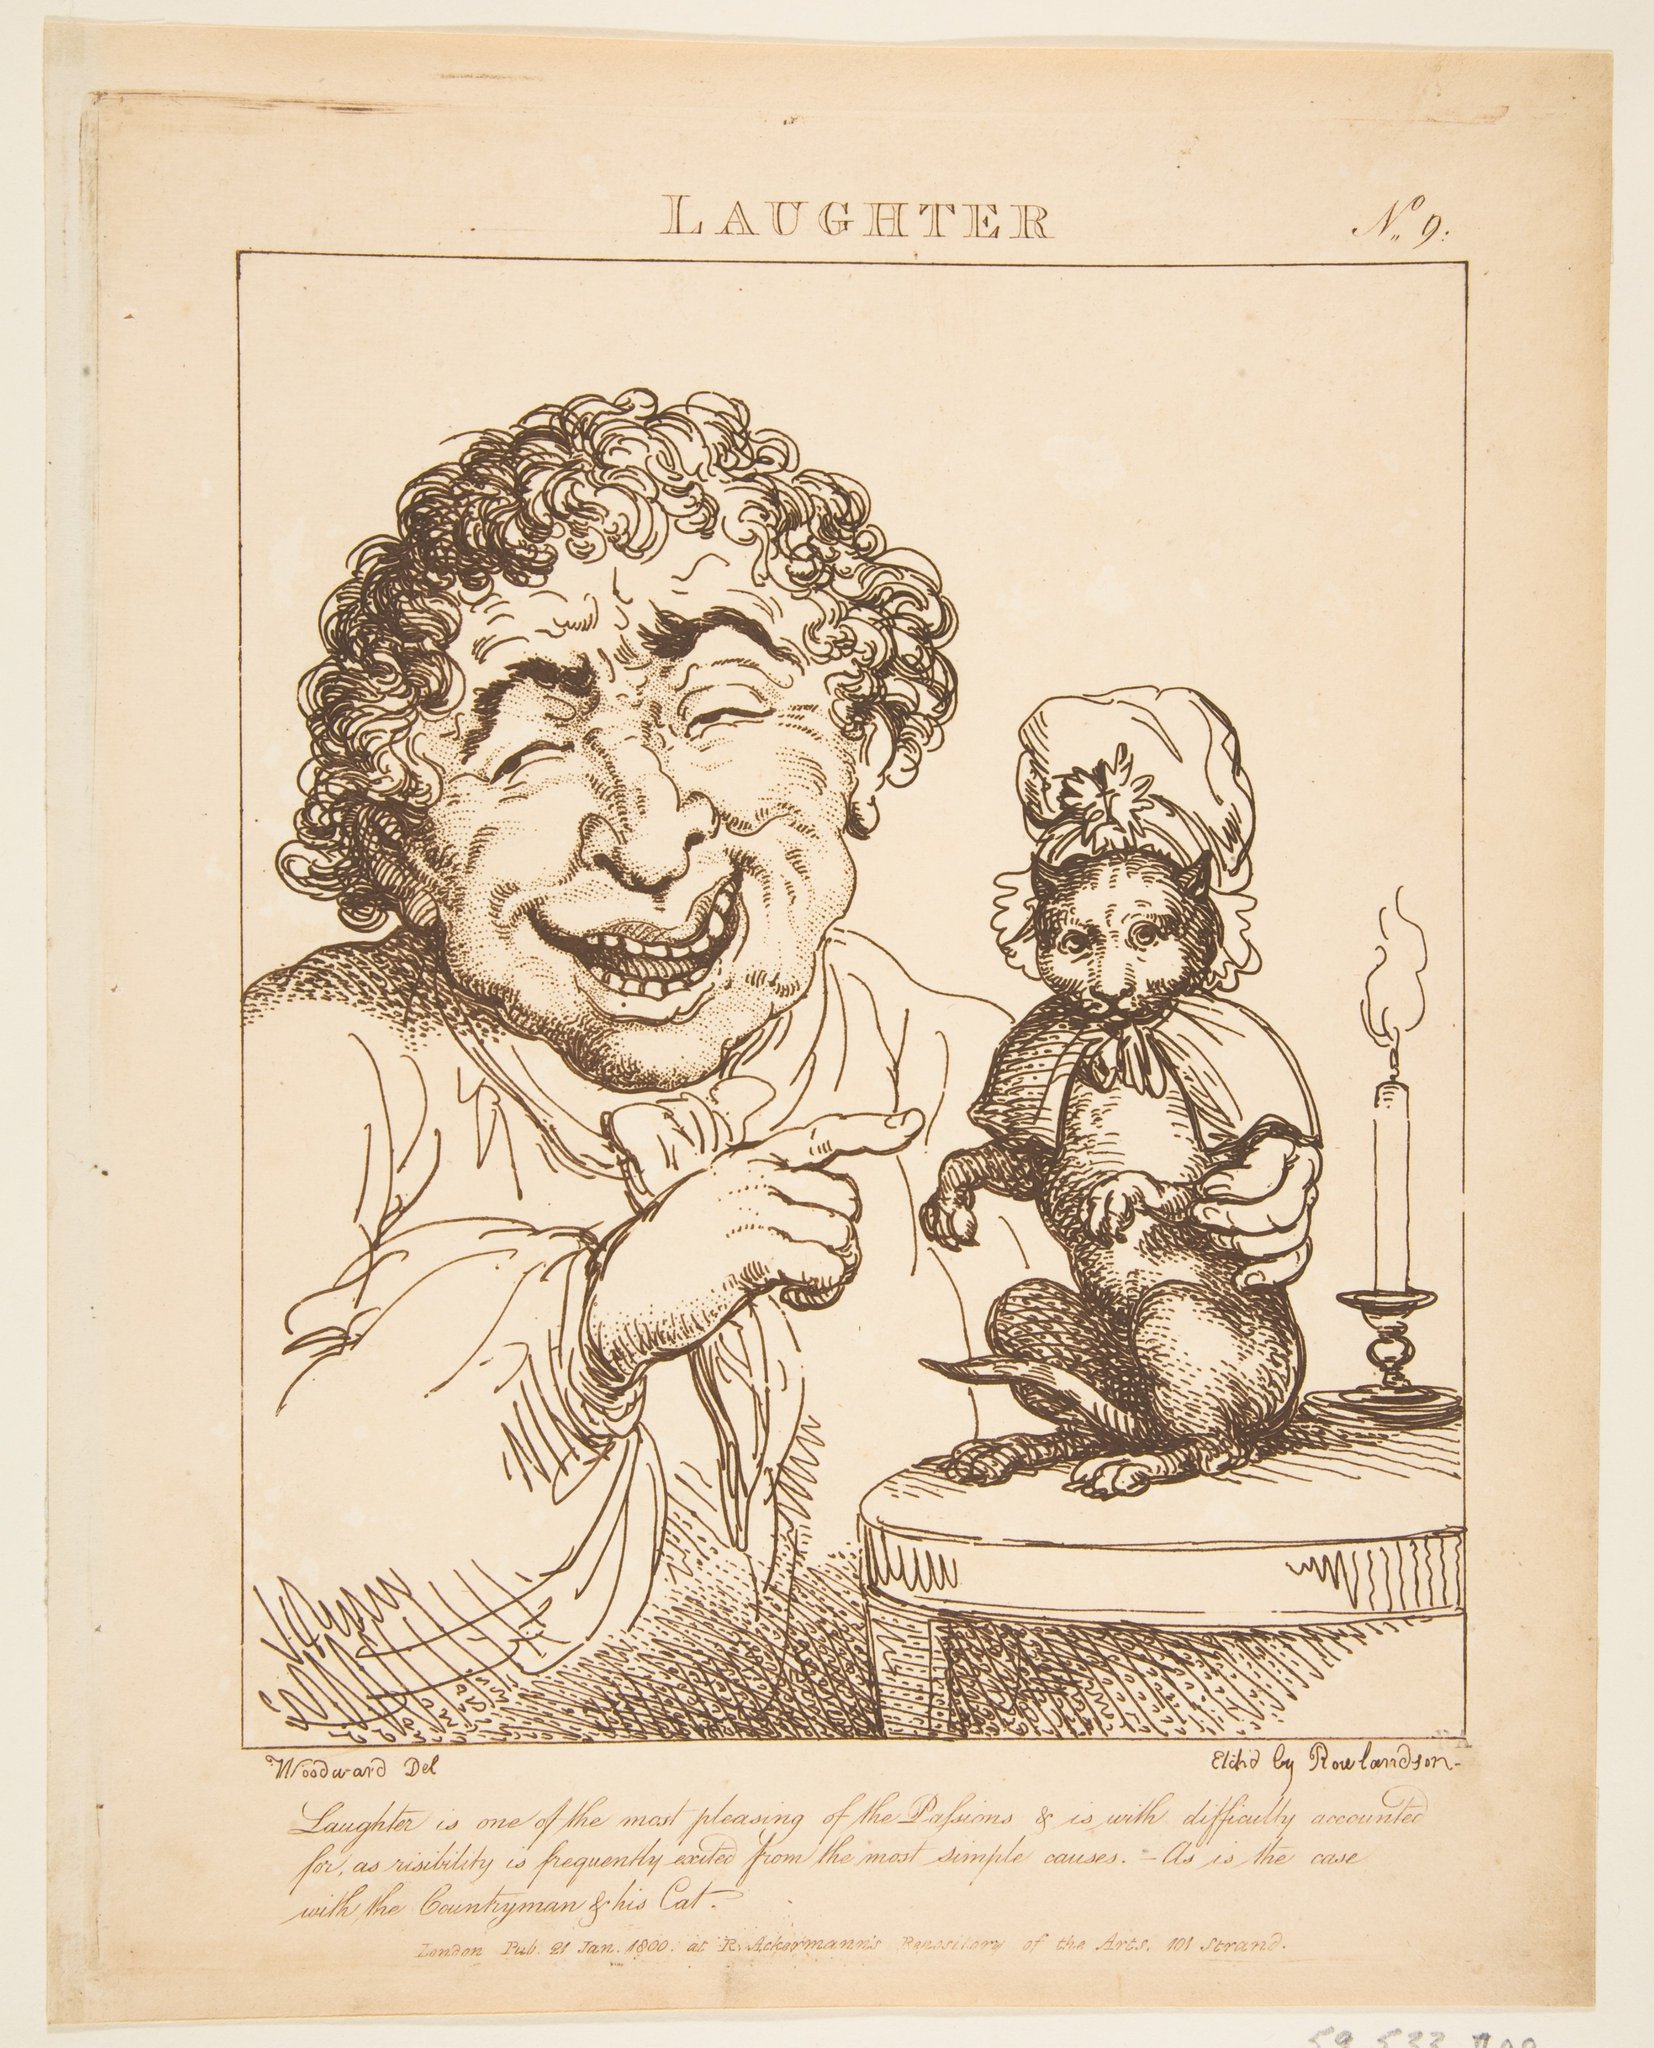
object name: print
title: Laughter (Le Brun Travested, or Caricatures of the Passions)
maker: thomas rowlandson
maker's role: artist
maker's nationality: british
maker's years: 1757-1827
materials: ink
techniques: etching, printing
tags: satire,men,cats